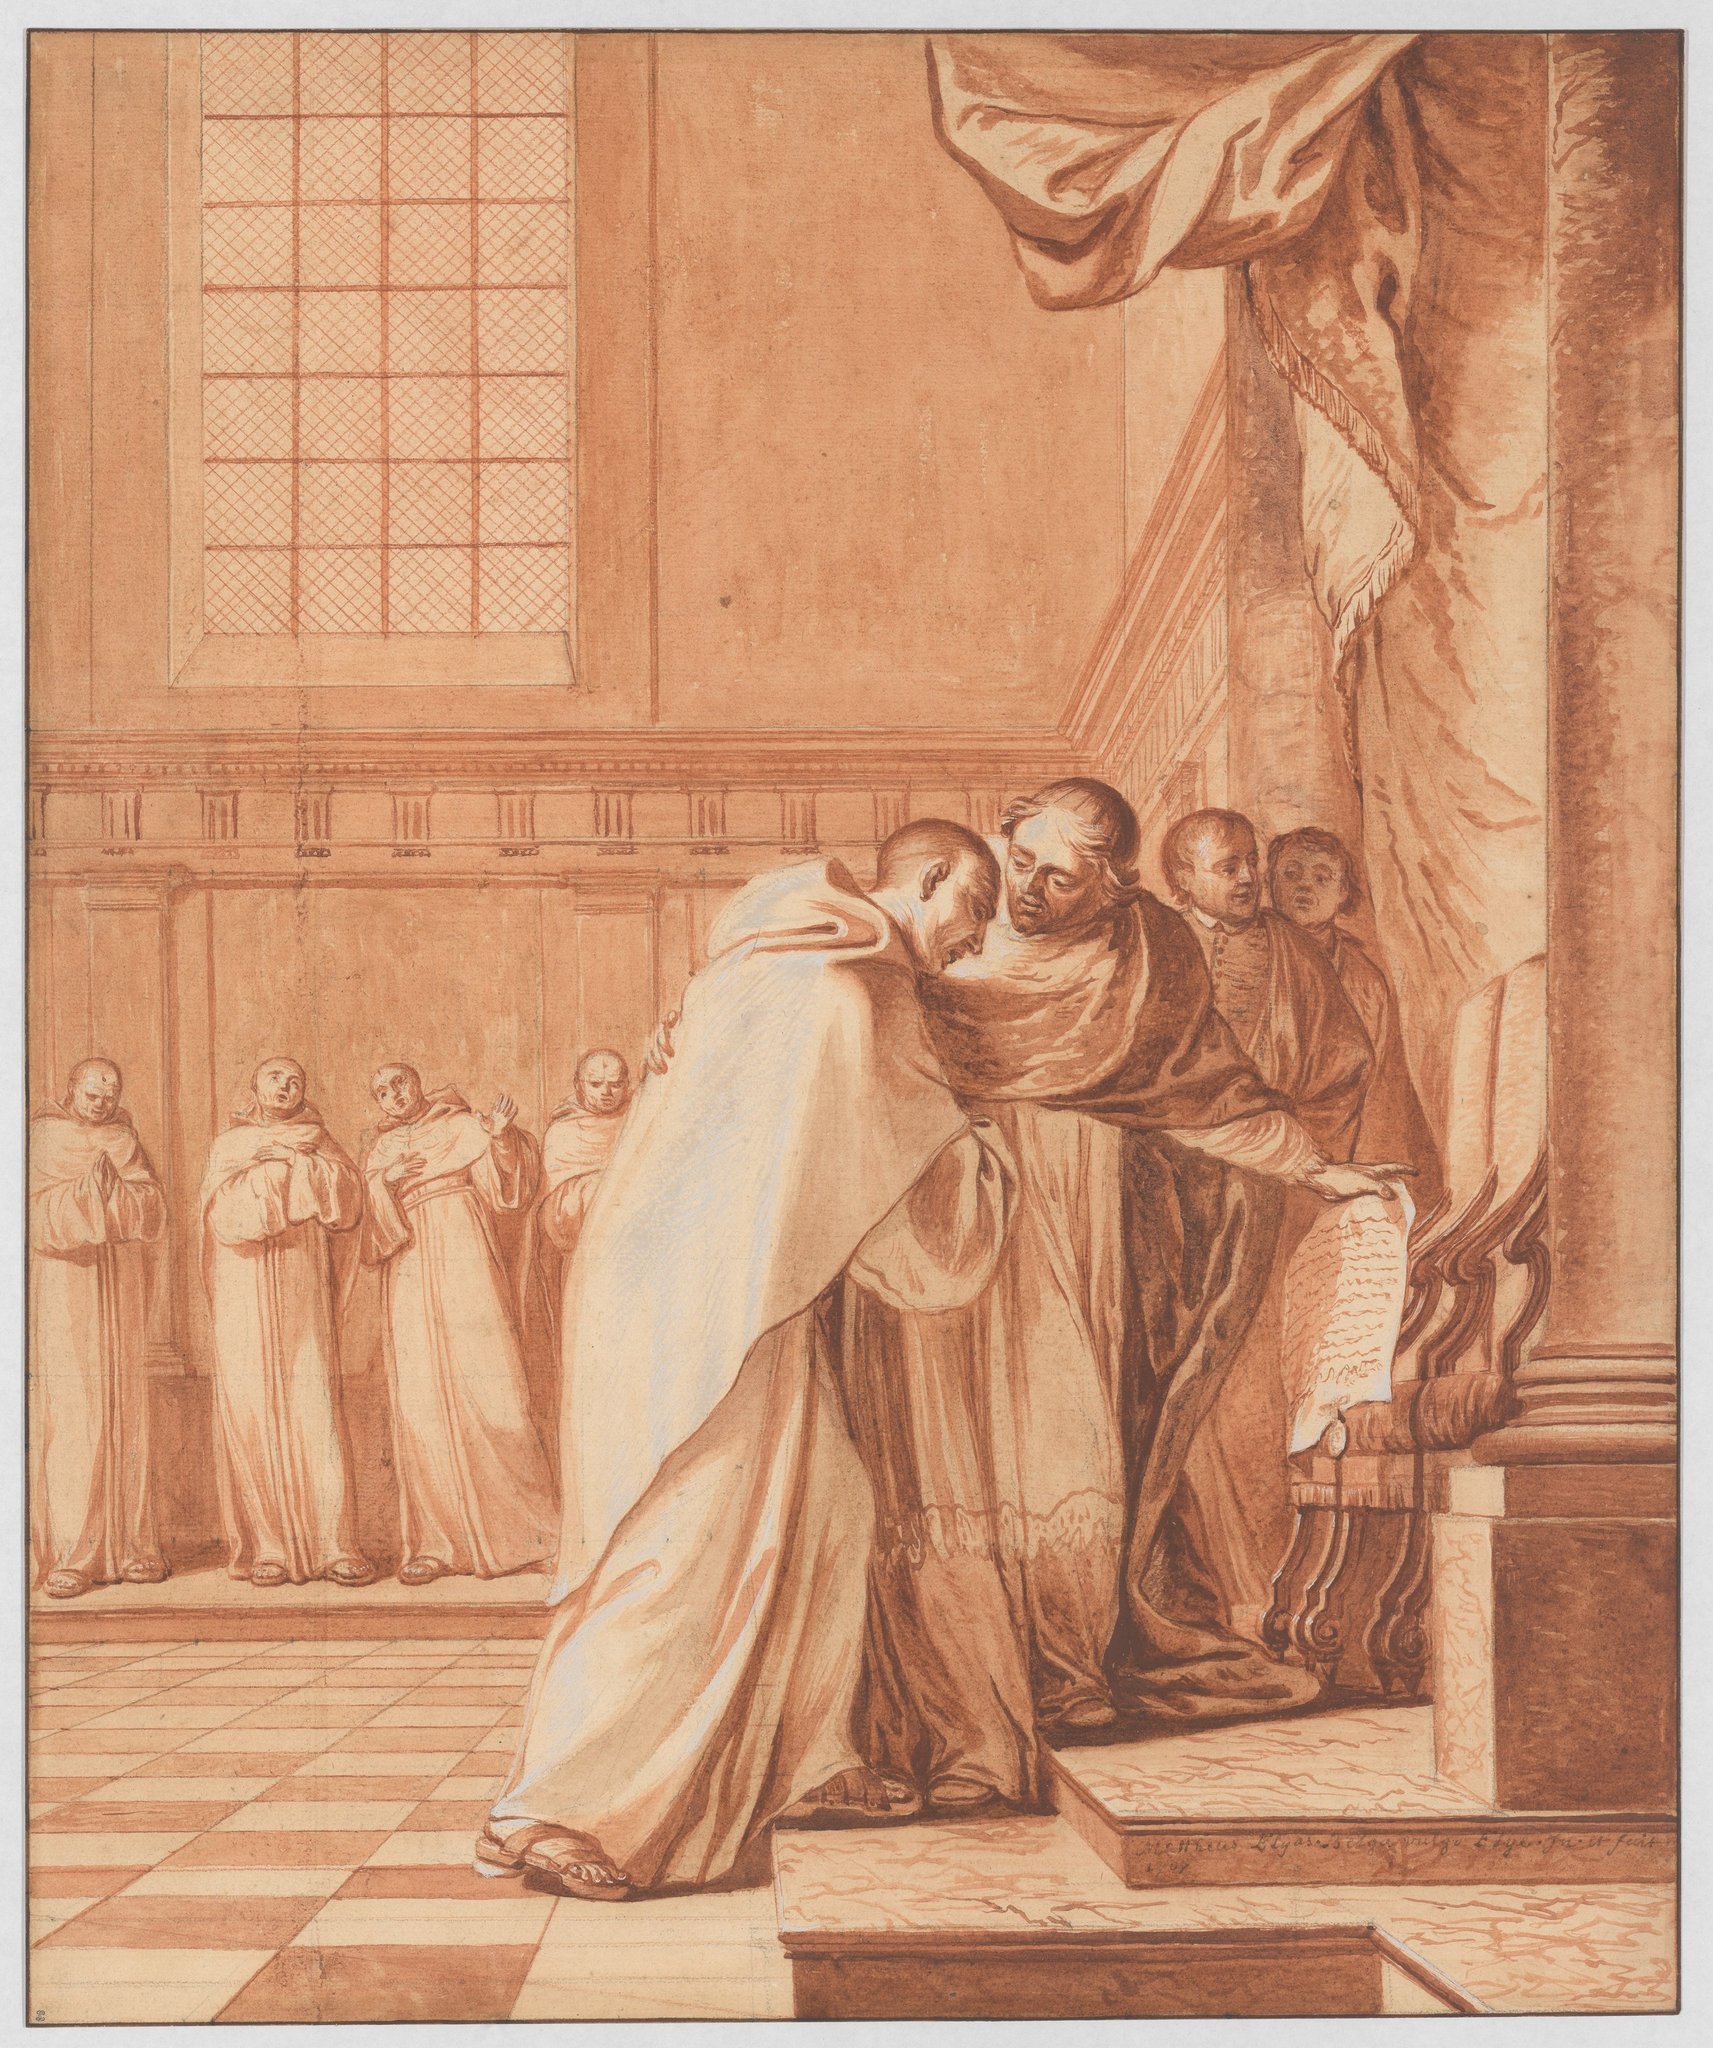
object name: drawing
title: Scene 32: Supporters of the league pursue the Blessed Abbot to Rome; despite their calumnies his innocence is recognized by the pope himself, who order Cardinal Bellarmine to restore all his posts and honors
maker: matthieu elias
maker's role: artist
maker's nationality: french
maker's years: 1658-1741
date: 1707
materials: chalk, graphite, ink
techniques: brush, heightening, pen, wash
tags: men